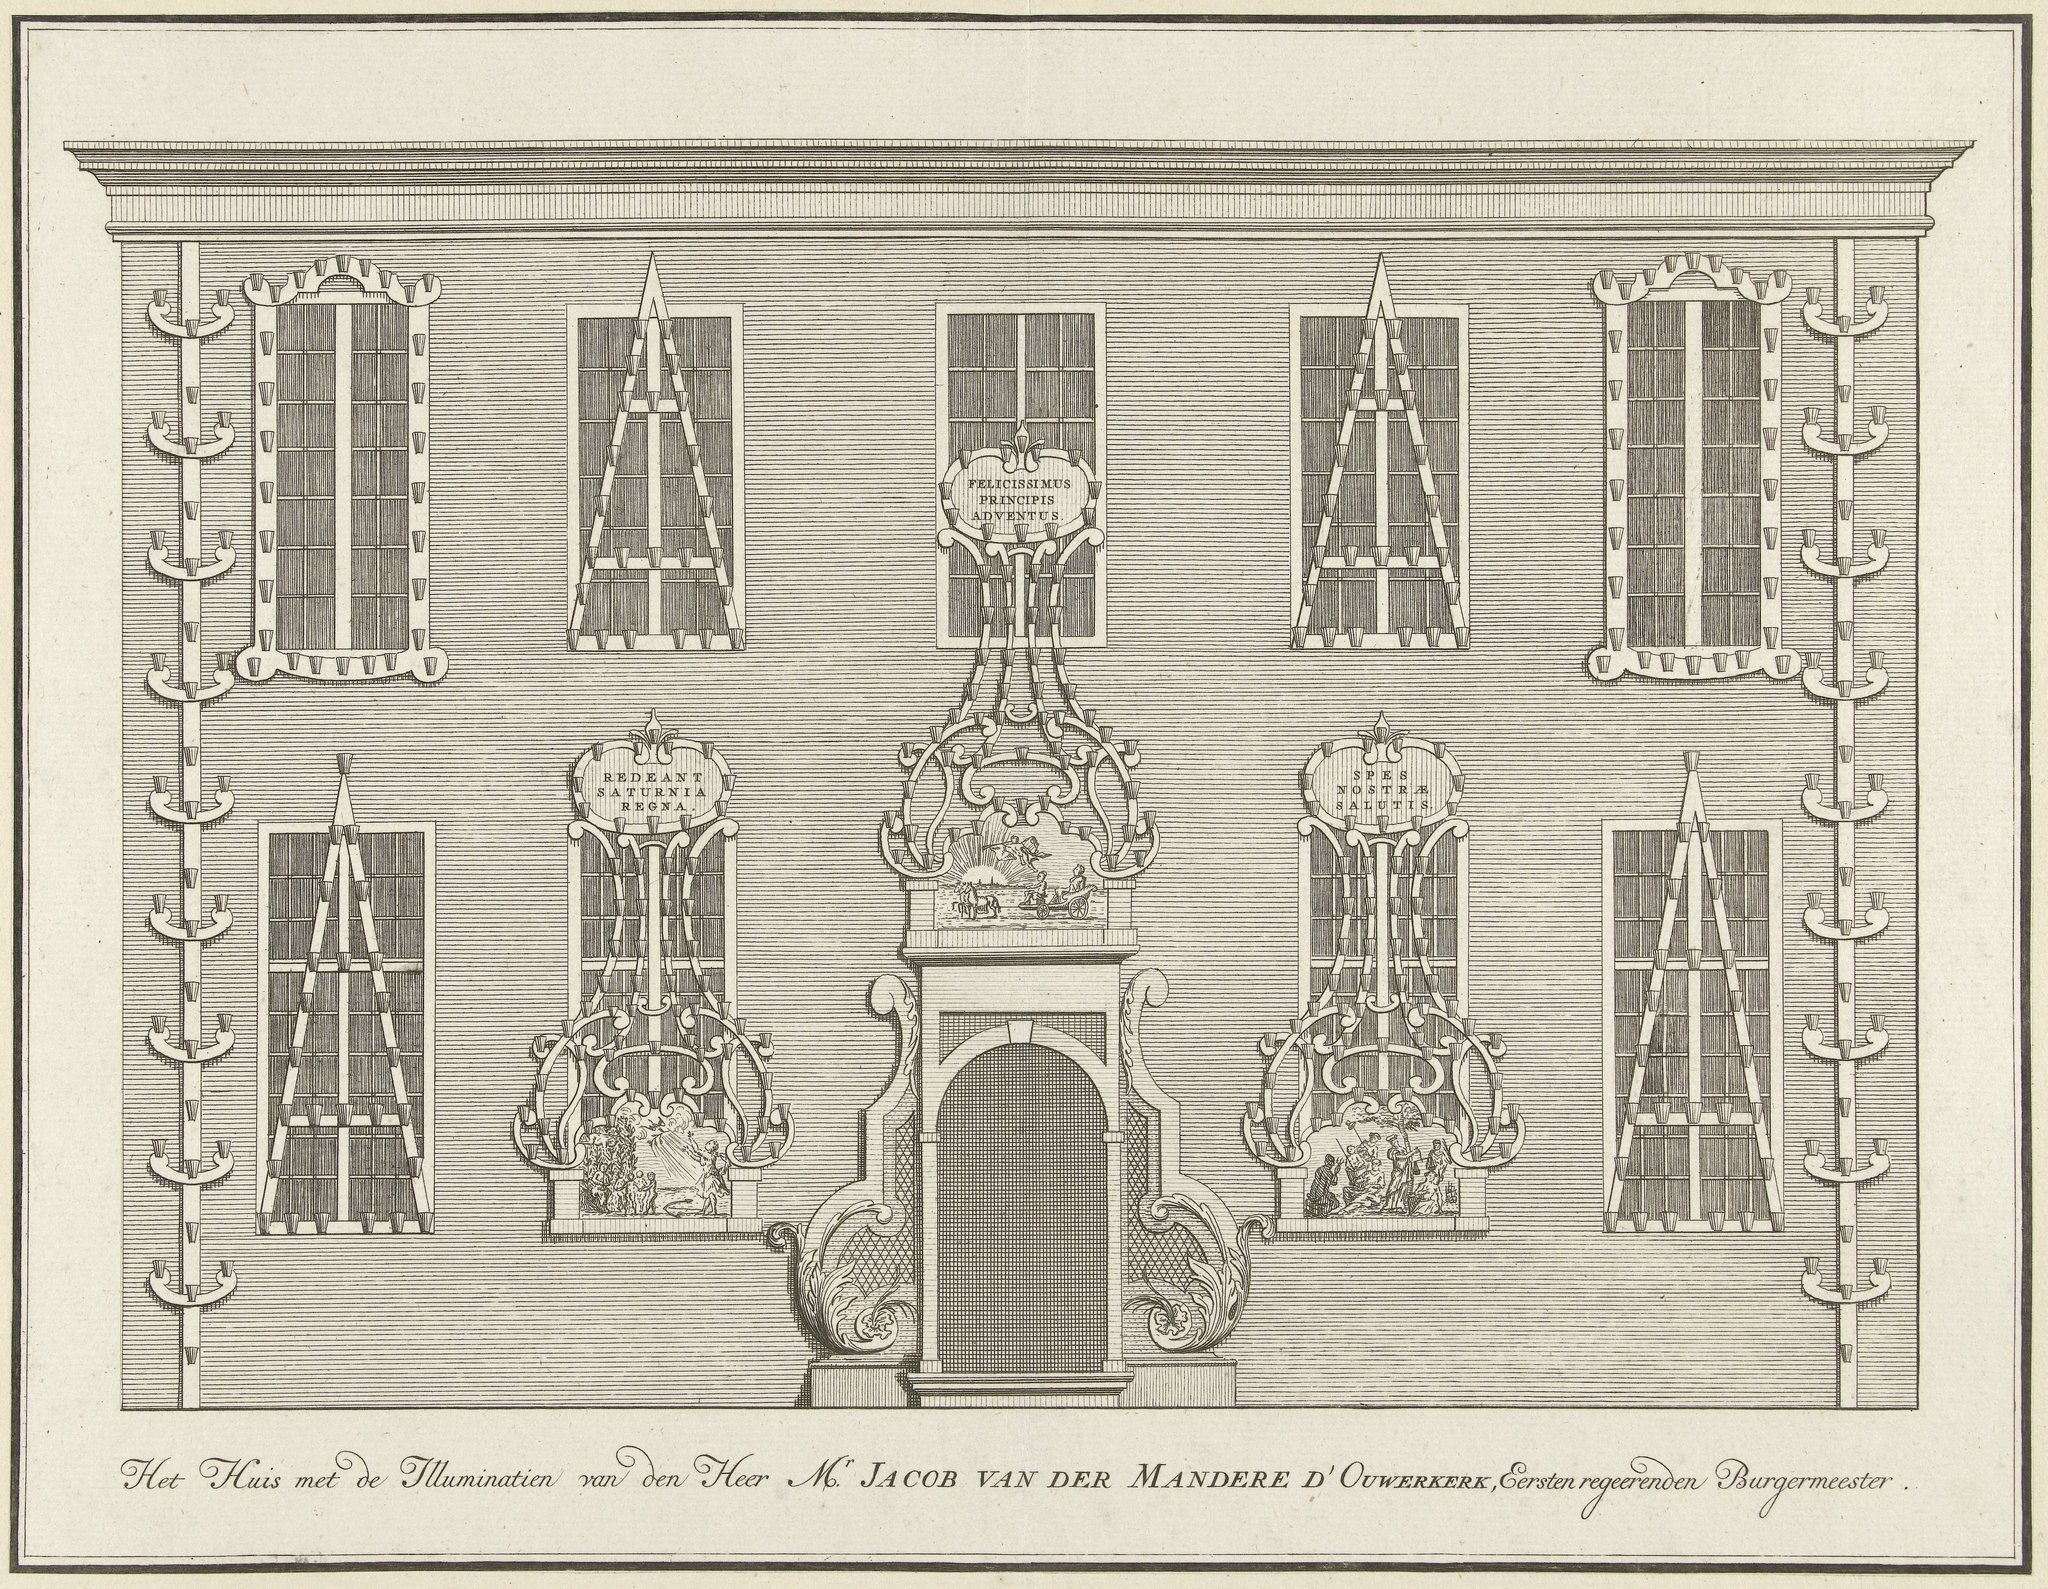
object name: book illustration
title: Het Huis met de Illuminatien van den Heer Mr. Jacob van der Mandere D'Ouwerkerk, Eersten regeerenden Bugermeester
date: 1753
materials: paper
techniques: etching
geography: northern netherlands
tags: the hague, willem iv (prins van oranje-nassau), decoration and illumination of streets, squares, etc. (~ triumphal entry, etc.) (+ illumination, fire-works ~ festive activities), flushing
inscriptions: collector's mark: Lugt 2228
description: Illuminatie aangebracht op de gevel van het huis van burgemeester Jacob van der Mandere d'Ouwerkerk ter ere van het bezoek van stadhouder Willem IV. Onderdeel van de illustraties van de inhuldiging van Willem IV als erfheer van Vlissingen op 5 juni 1751.